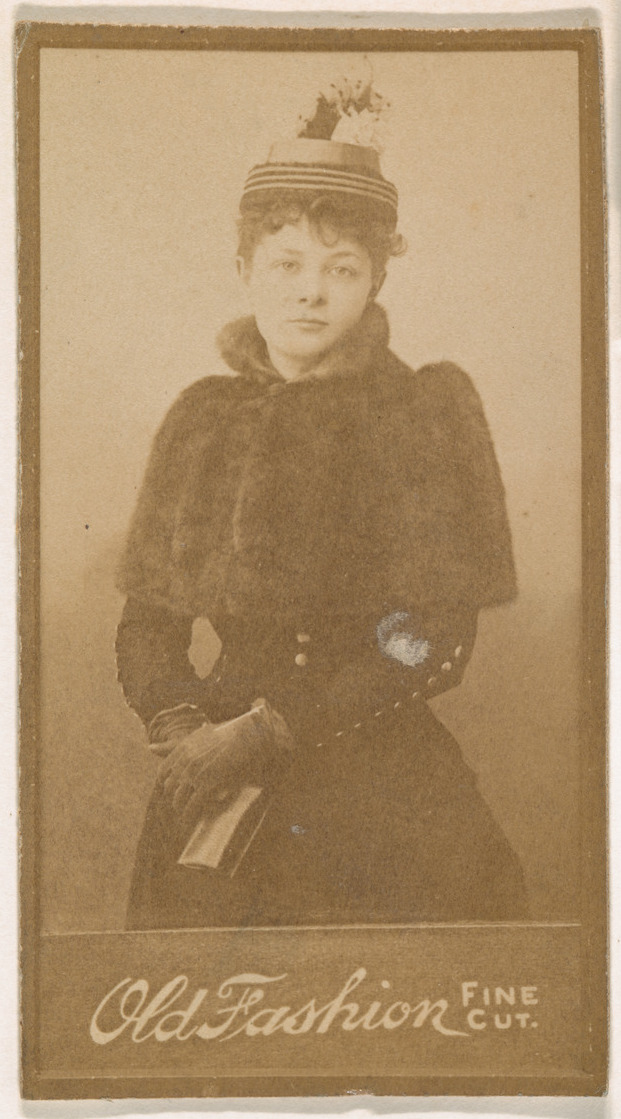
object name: photograph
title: Actress wearing striped hat, from the Actresses series (N664) promoting Old Fashion Fine Cut Tobacco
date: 1888-1890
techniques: albumen silver print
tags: portraits,women,actresses